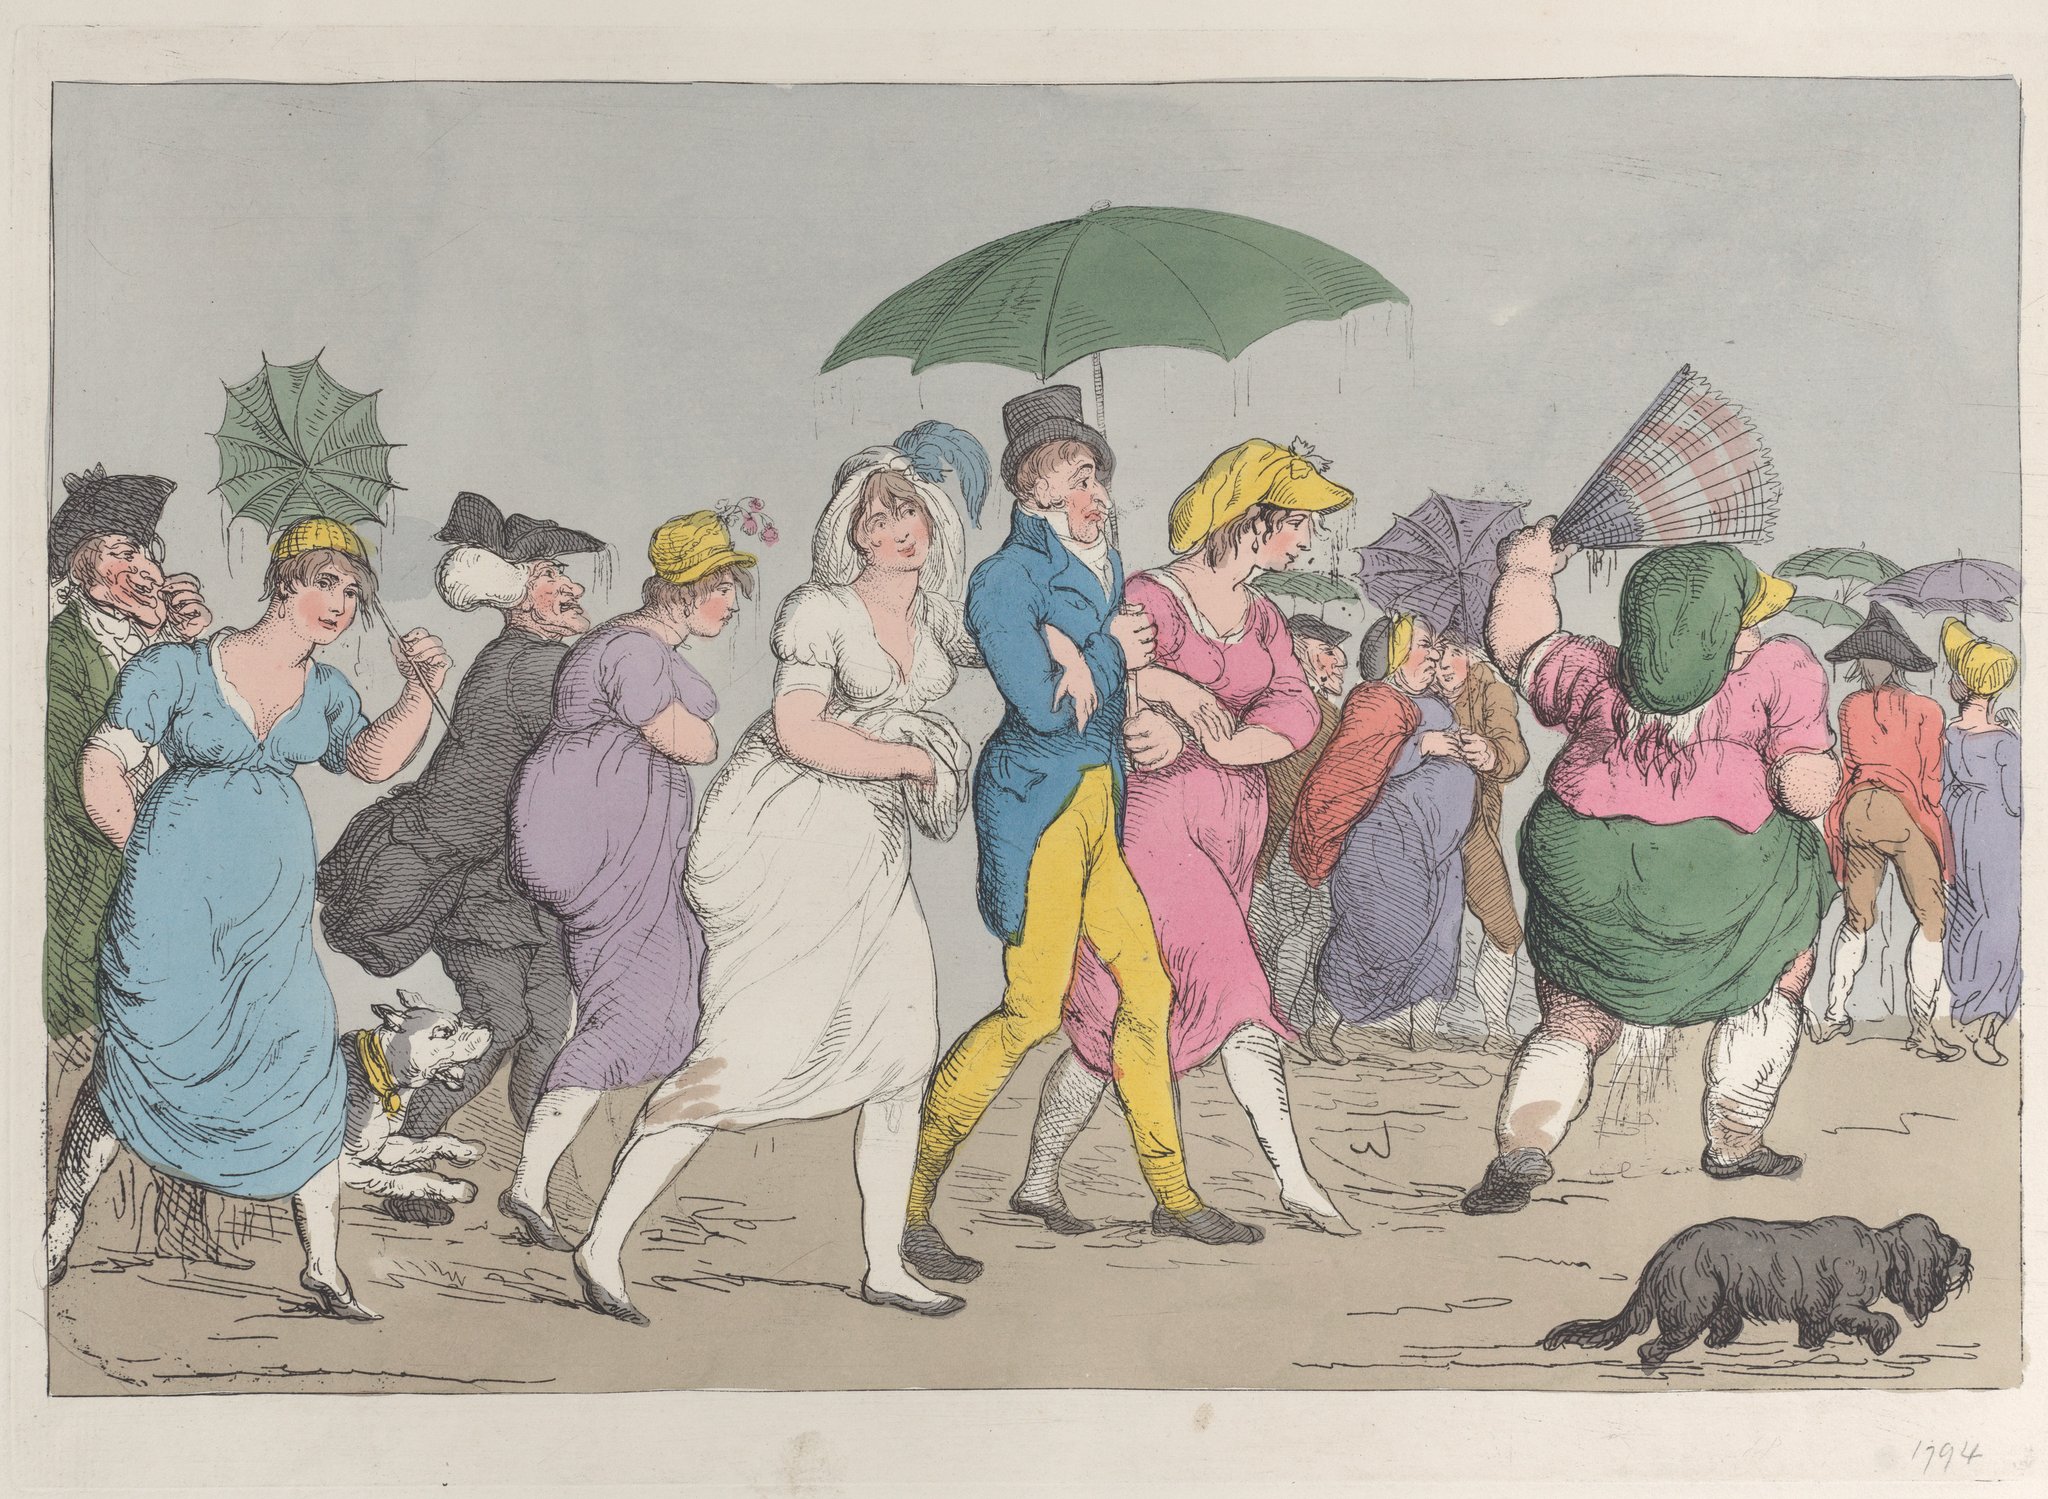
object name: print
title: Returning from the Review (Loyal Ducking)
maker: thomas rowlandson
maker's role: artist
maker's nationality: british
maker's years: 1757-1827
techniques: etching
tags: satire,men,women,dogs,umbrellas